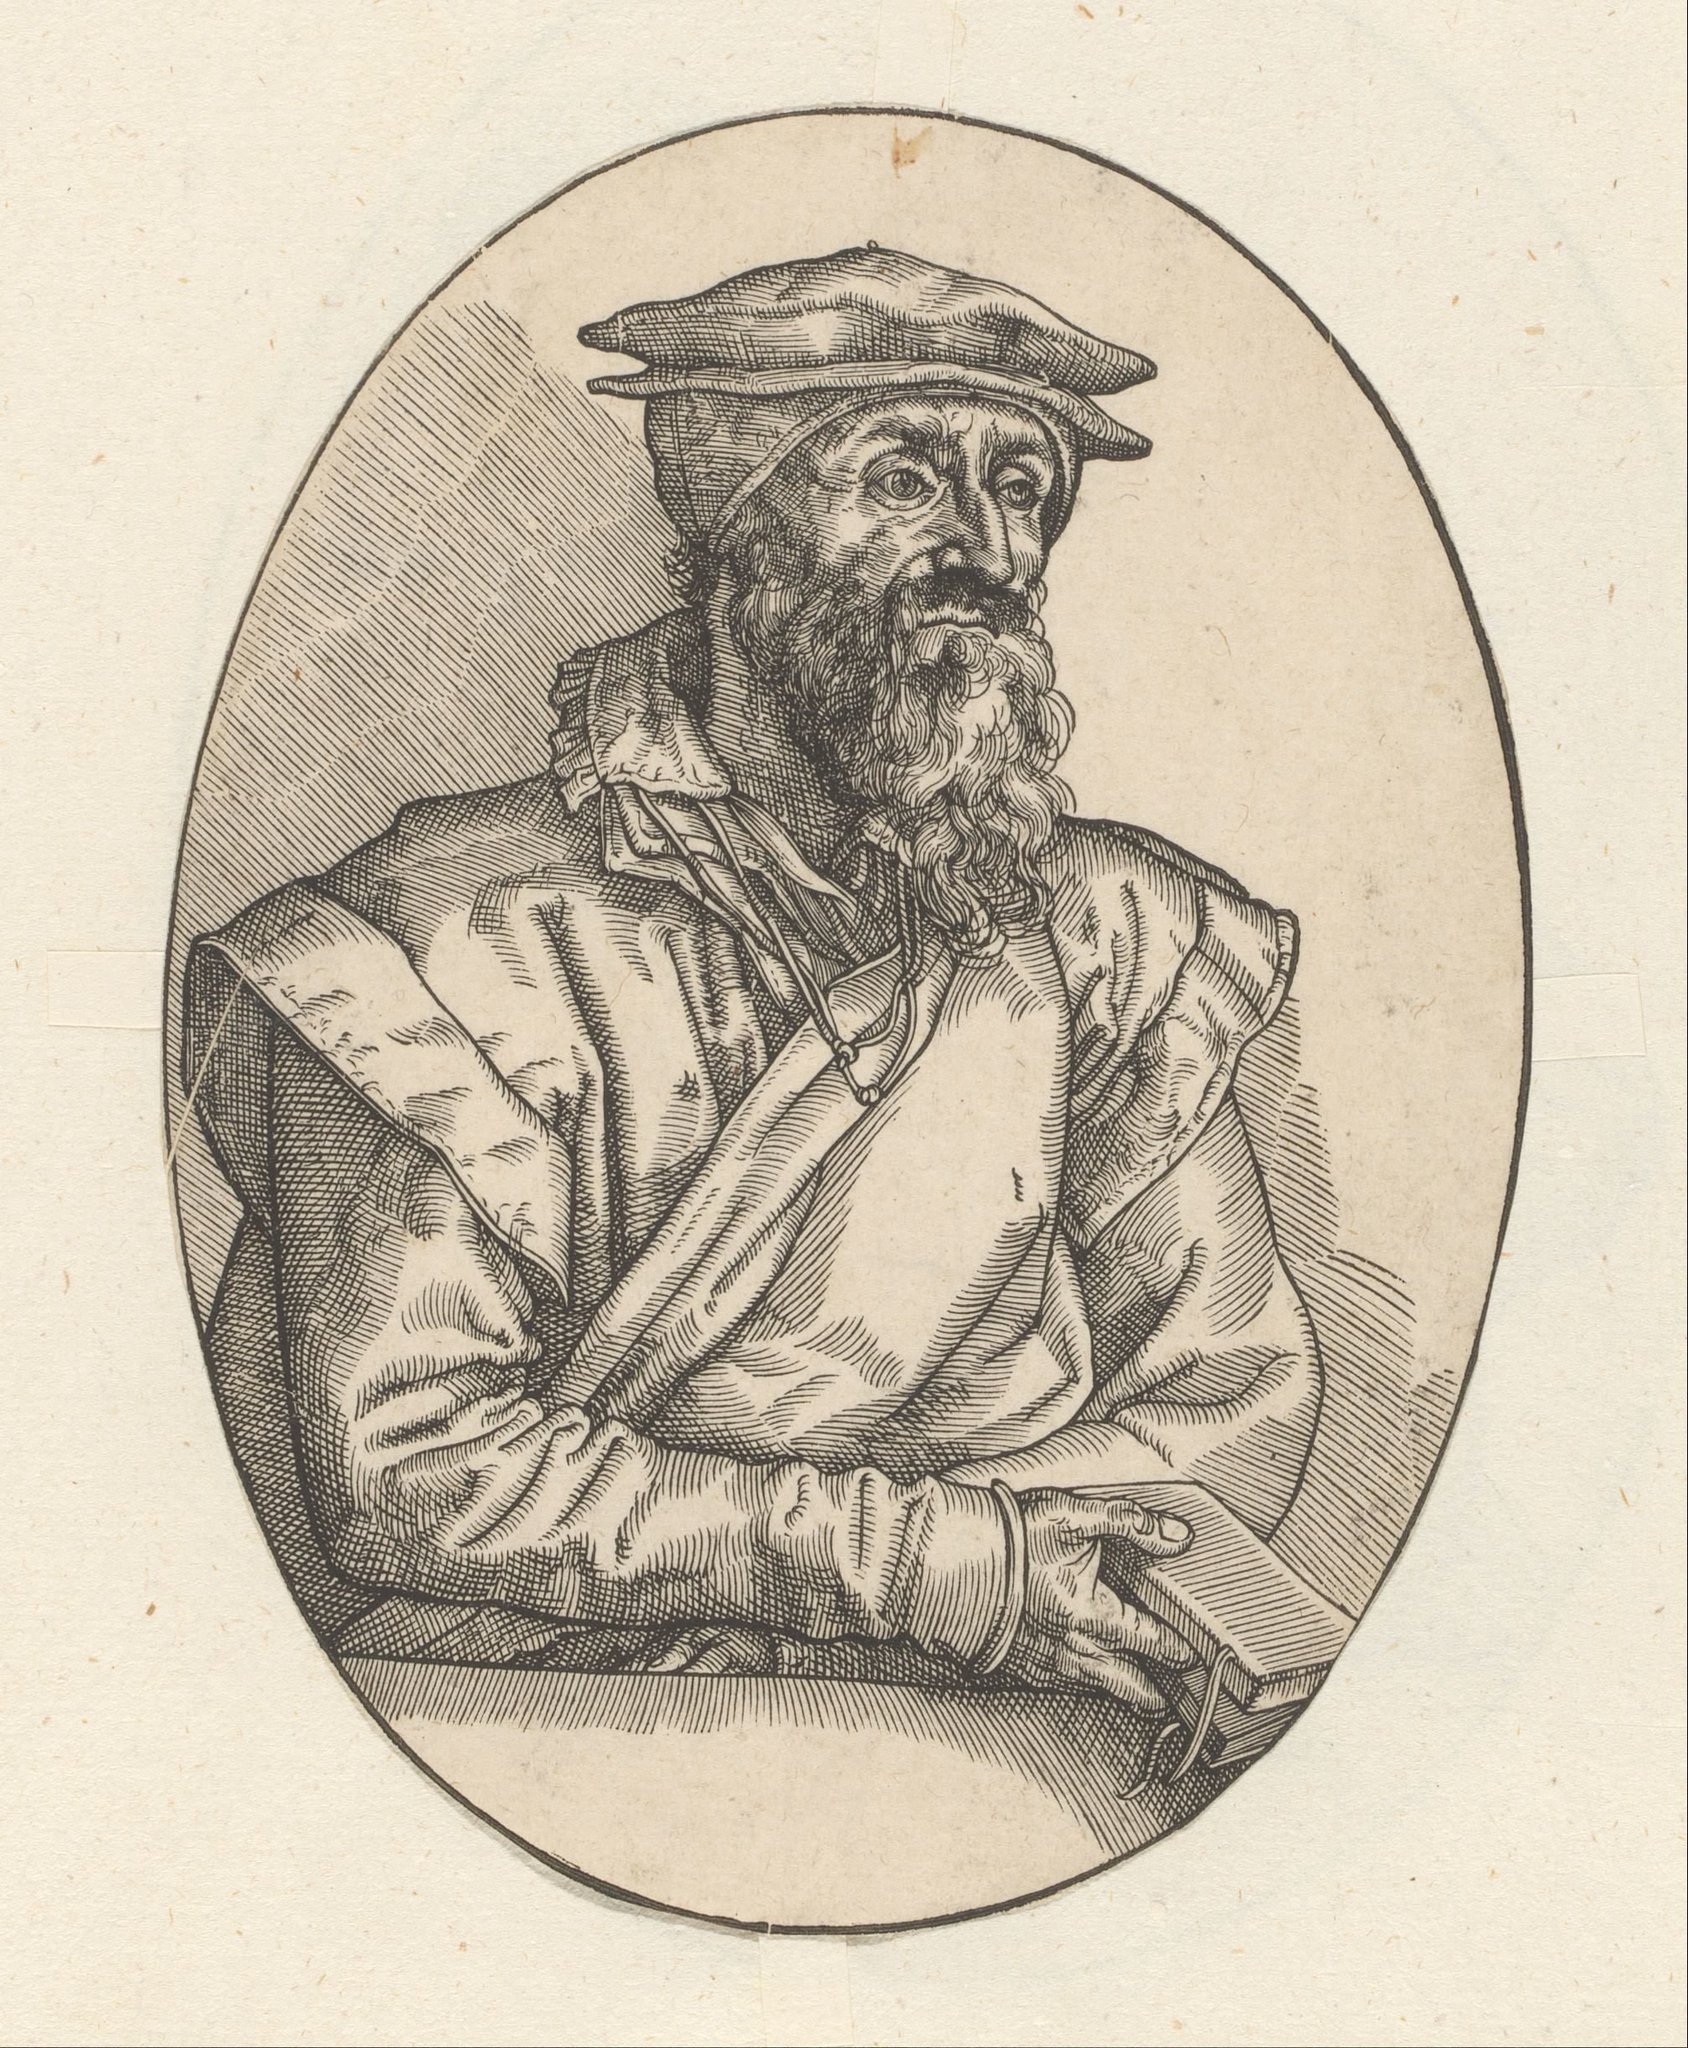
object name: album leaf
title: Portret van Matthias Flacius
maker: Anonymous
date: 1549-1584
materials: paper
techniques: woodcut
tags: theologian, historical persons